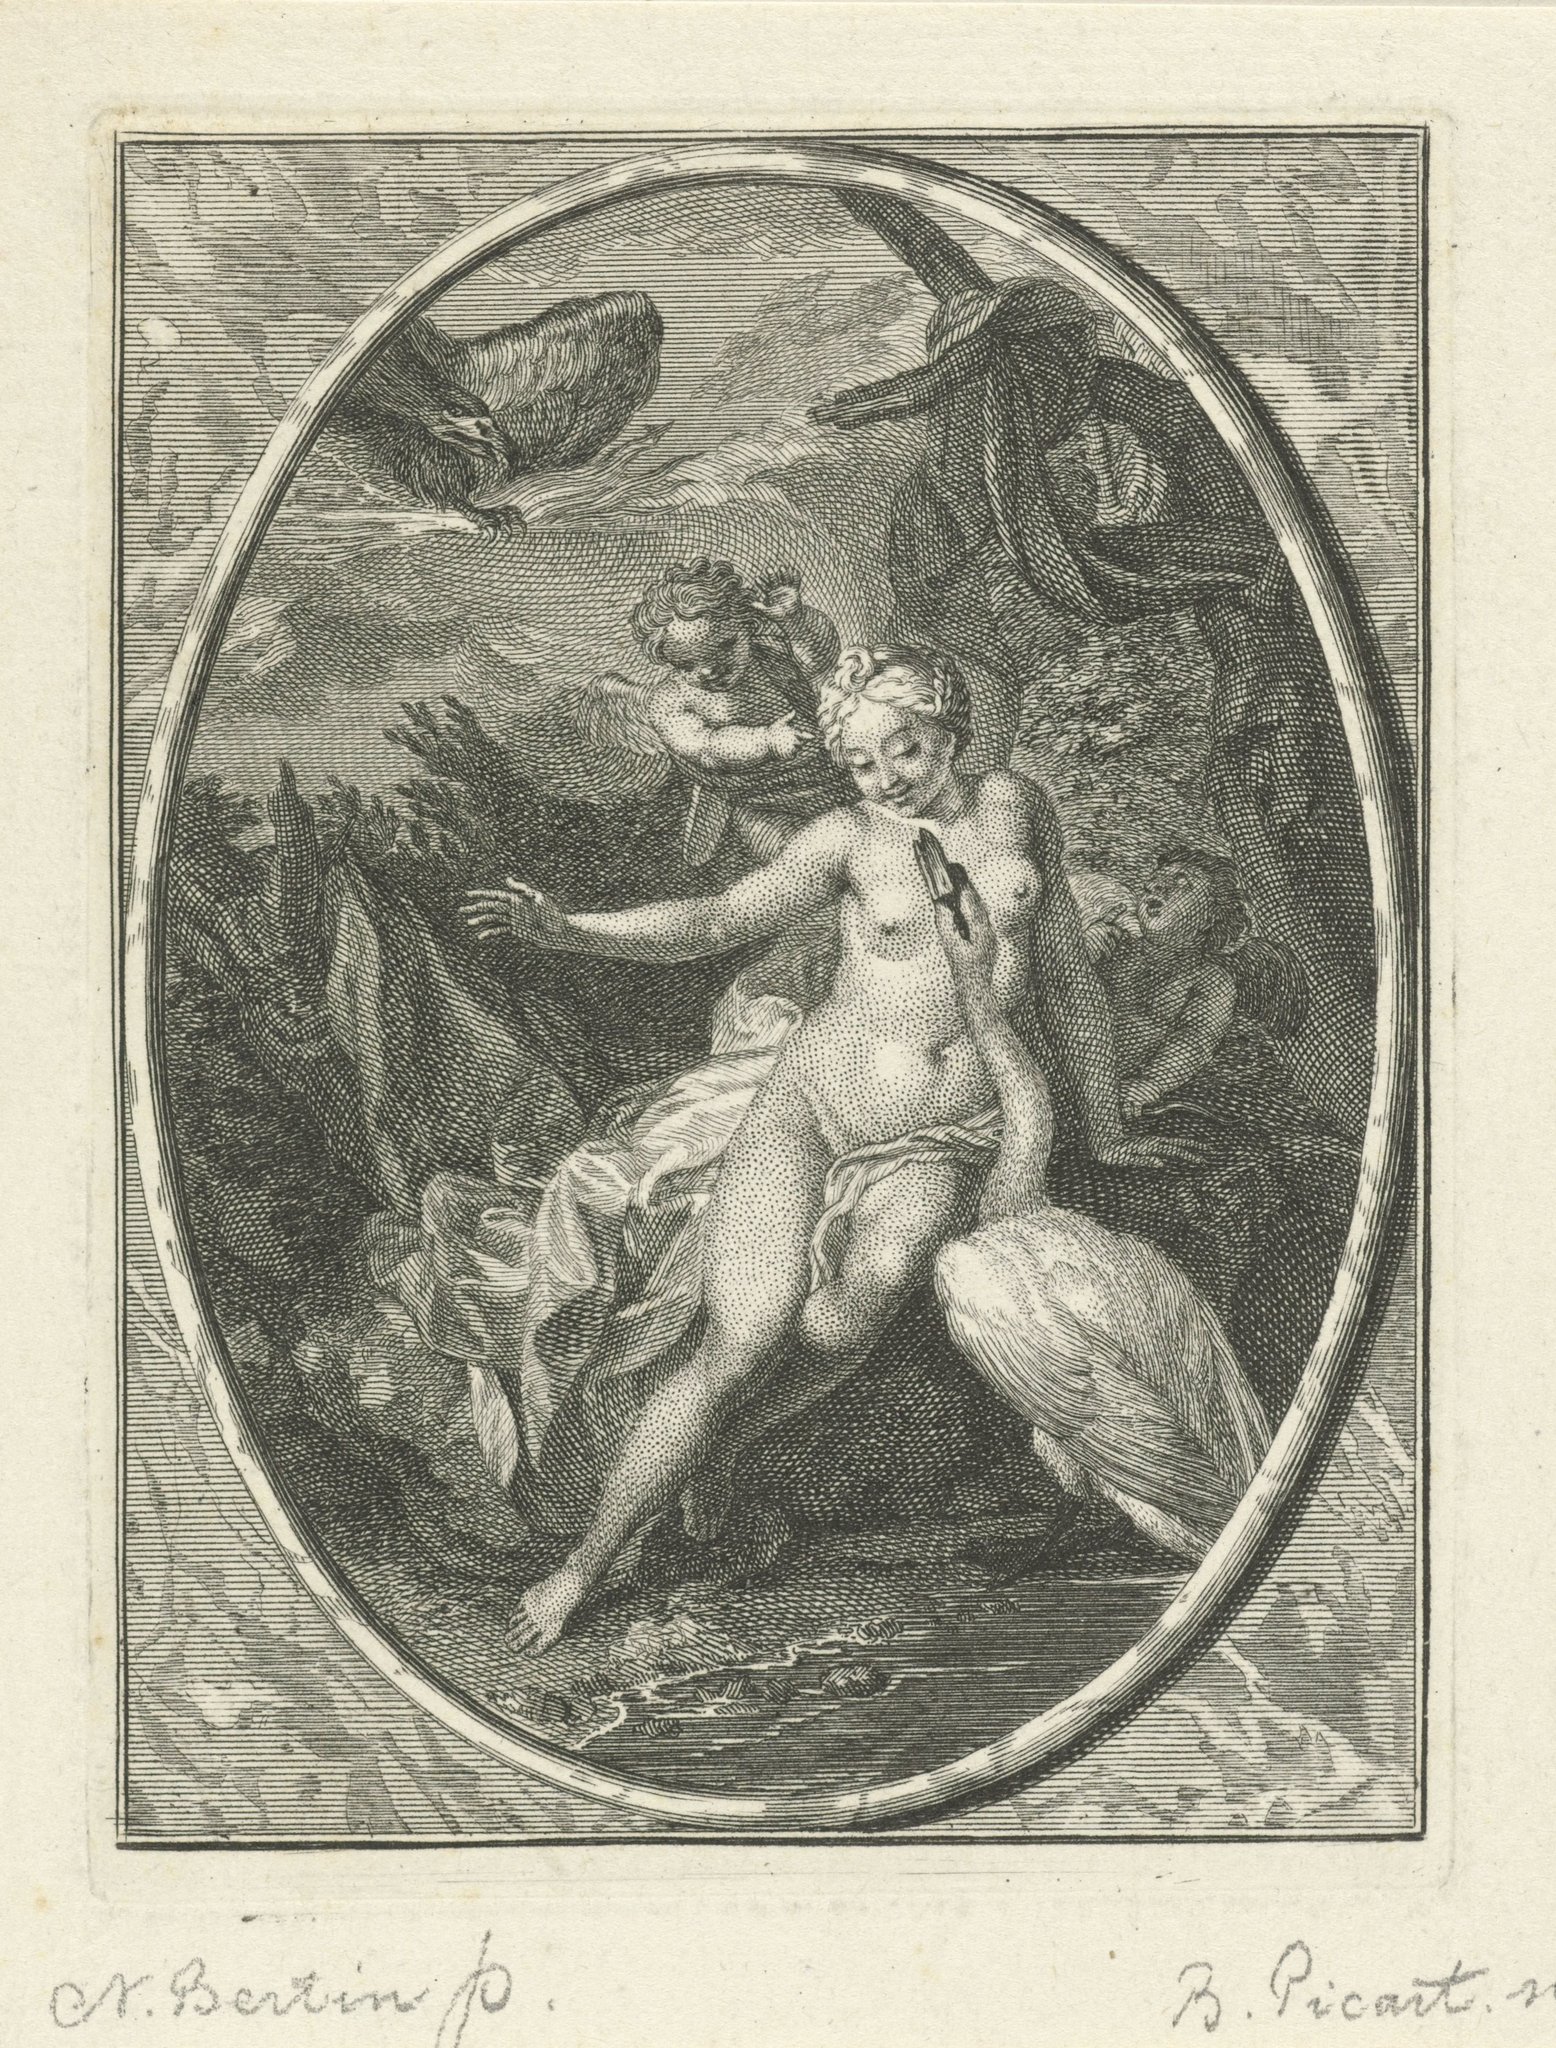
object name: print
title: Leda en de zwaan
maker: bernard picart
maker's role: draughtsman, print maker, publisher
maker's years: 1673-1733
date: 1705-1733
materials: paper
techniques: engraving, etching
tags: jupiter, in the shape of a swan, and leda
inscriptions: collector's mark: Lugt 2228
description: Leda wordt bij de rivier bezocht door Jupiter. Hij probeert haar te verleiden in de gedaante van een zwaan. In de lucht zijn attribuut de adelaar.